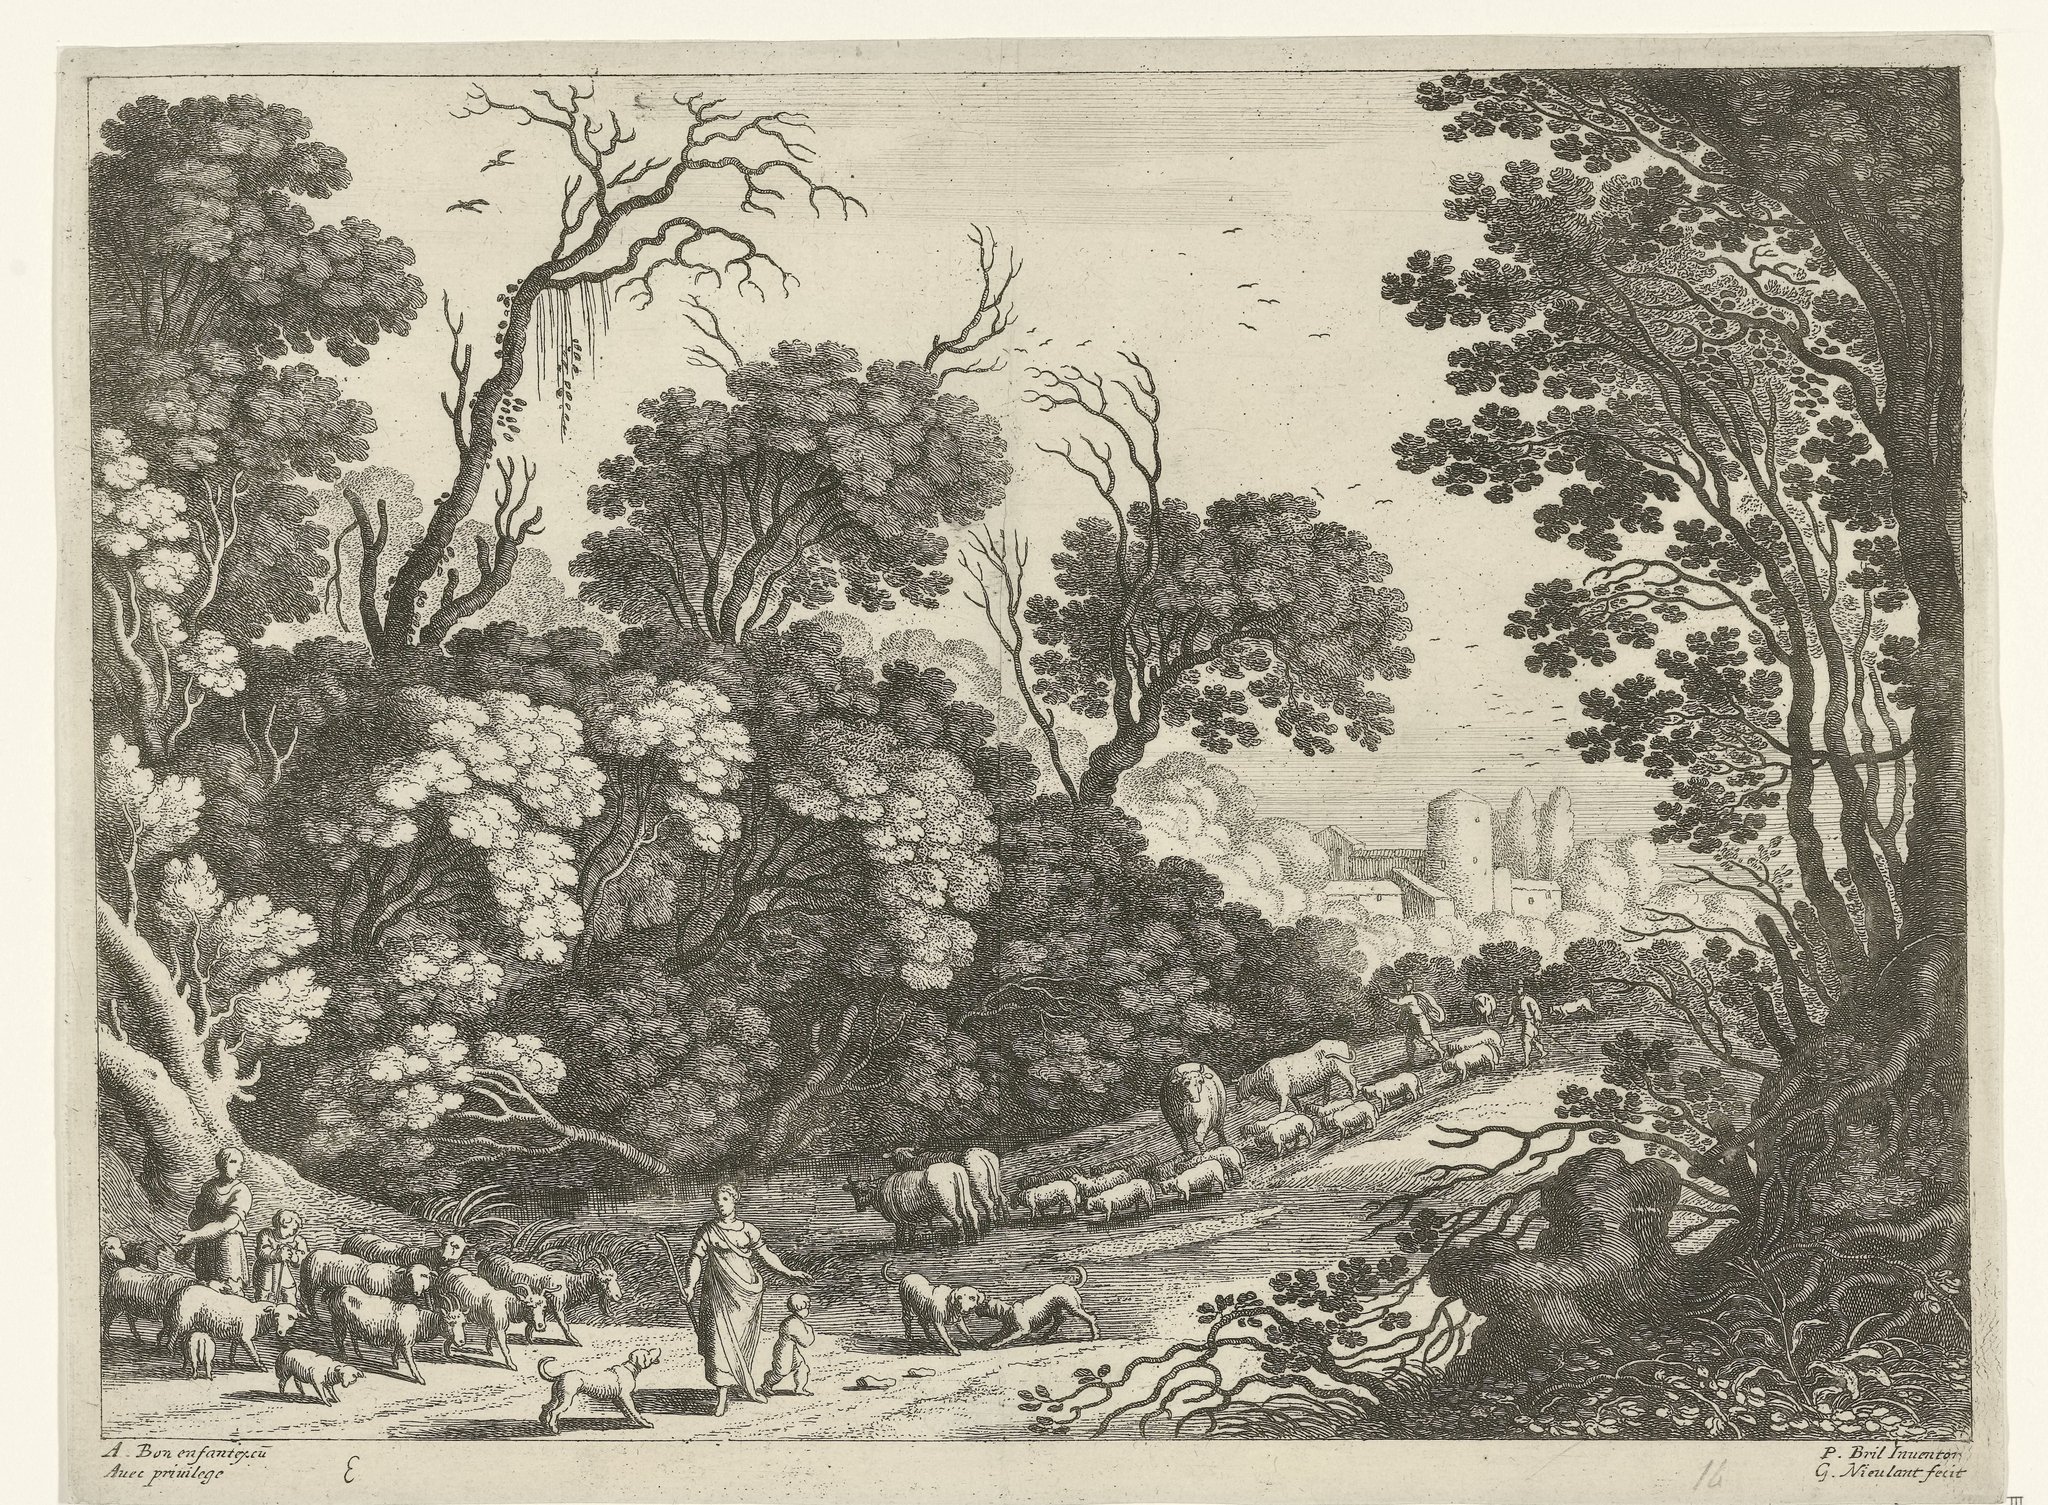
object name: print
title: Italiaanse landschappen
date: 1594-1635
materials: paper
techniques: engraving, etching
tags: cattle, forest, wood, pastorals, arcadian scenes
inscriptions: collector's mark: Lugt 2228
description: Op een weg in een bos lopen een man en een vrouw met twee kinderen, wat honden en een kudde geiten en schapen. Op de achtergrond twee herders met een kudde schapen en runderen.